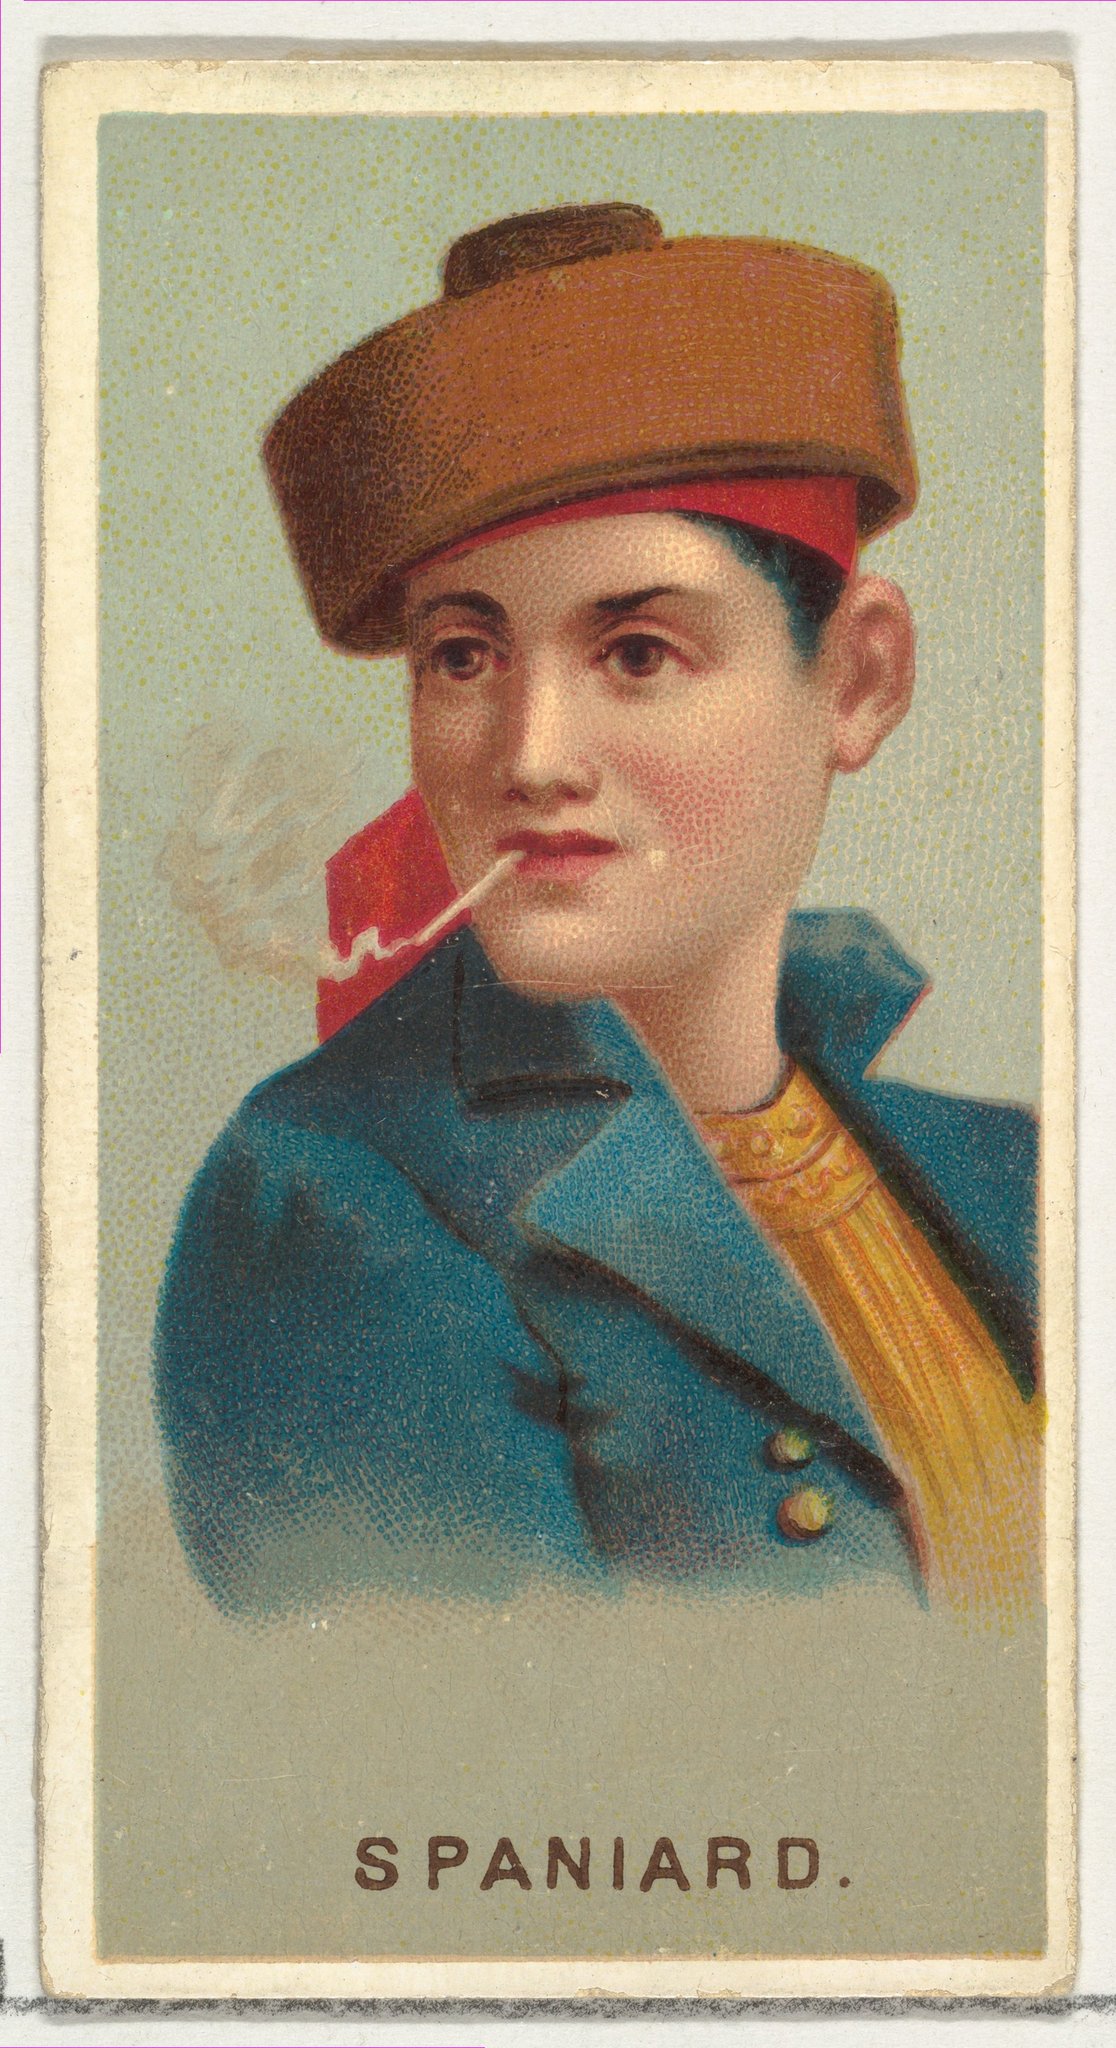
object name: print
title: Spaniard, from World's Smokers series (N33) for Allen & Ginter Cigarettes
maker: allen & ginter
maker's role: publisher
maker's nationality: american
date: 1888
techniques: color lithograph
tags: men,smoking